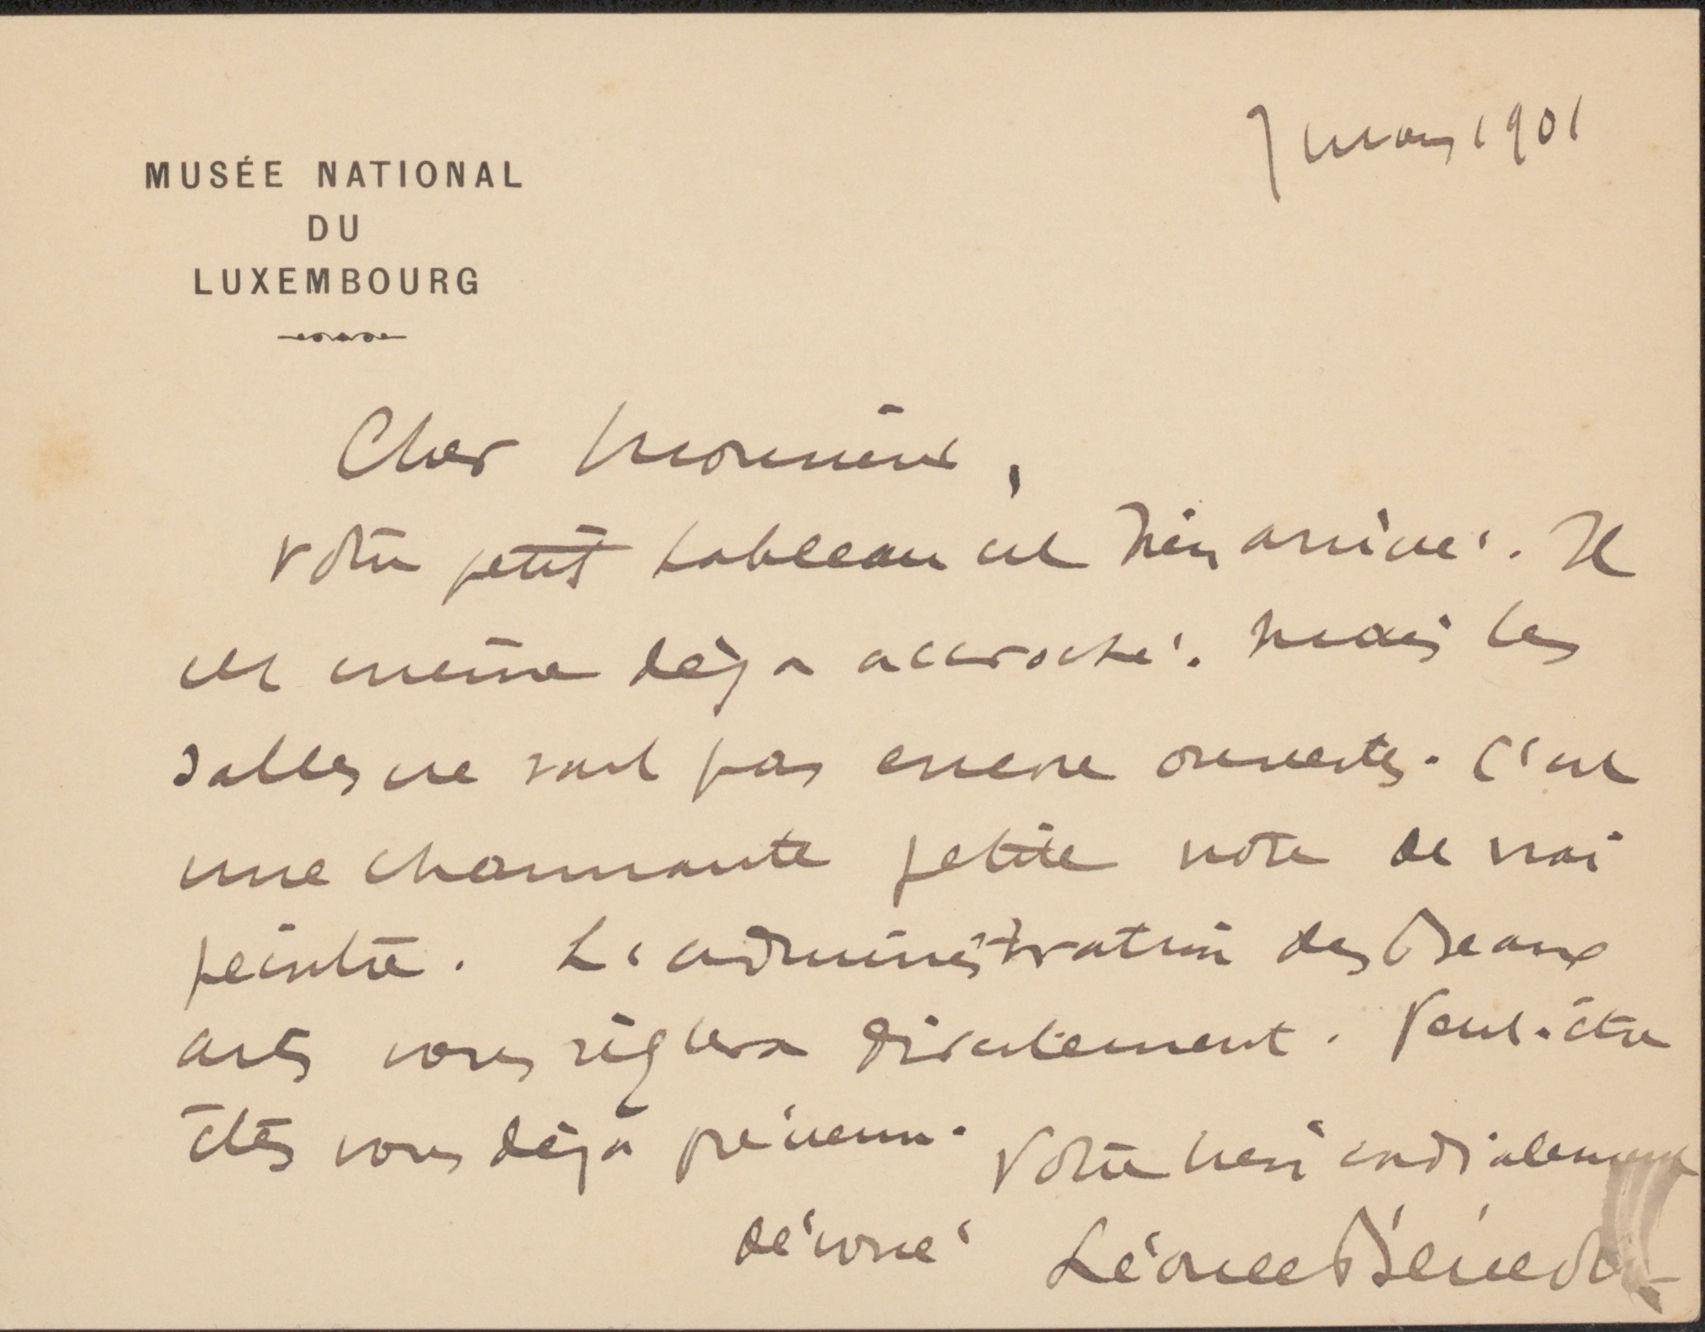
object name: letter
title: Brief aan Philip Zilcken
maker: léonce bénédite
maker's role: conservator, museumdirecteur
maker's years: 1856-1925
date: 1901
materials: ink, paper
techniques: pen, printing, writing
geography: paris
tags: the hague, painter, philip zilcken, painting (including book-illumination, miniature-painting)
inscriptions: collector's mark: ‘RPK’